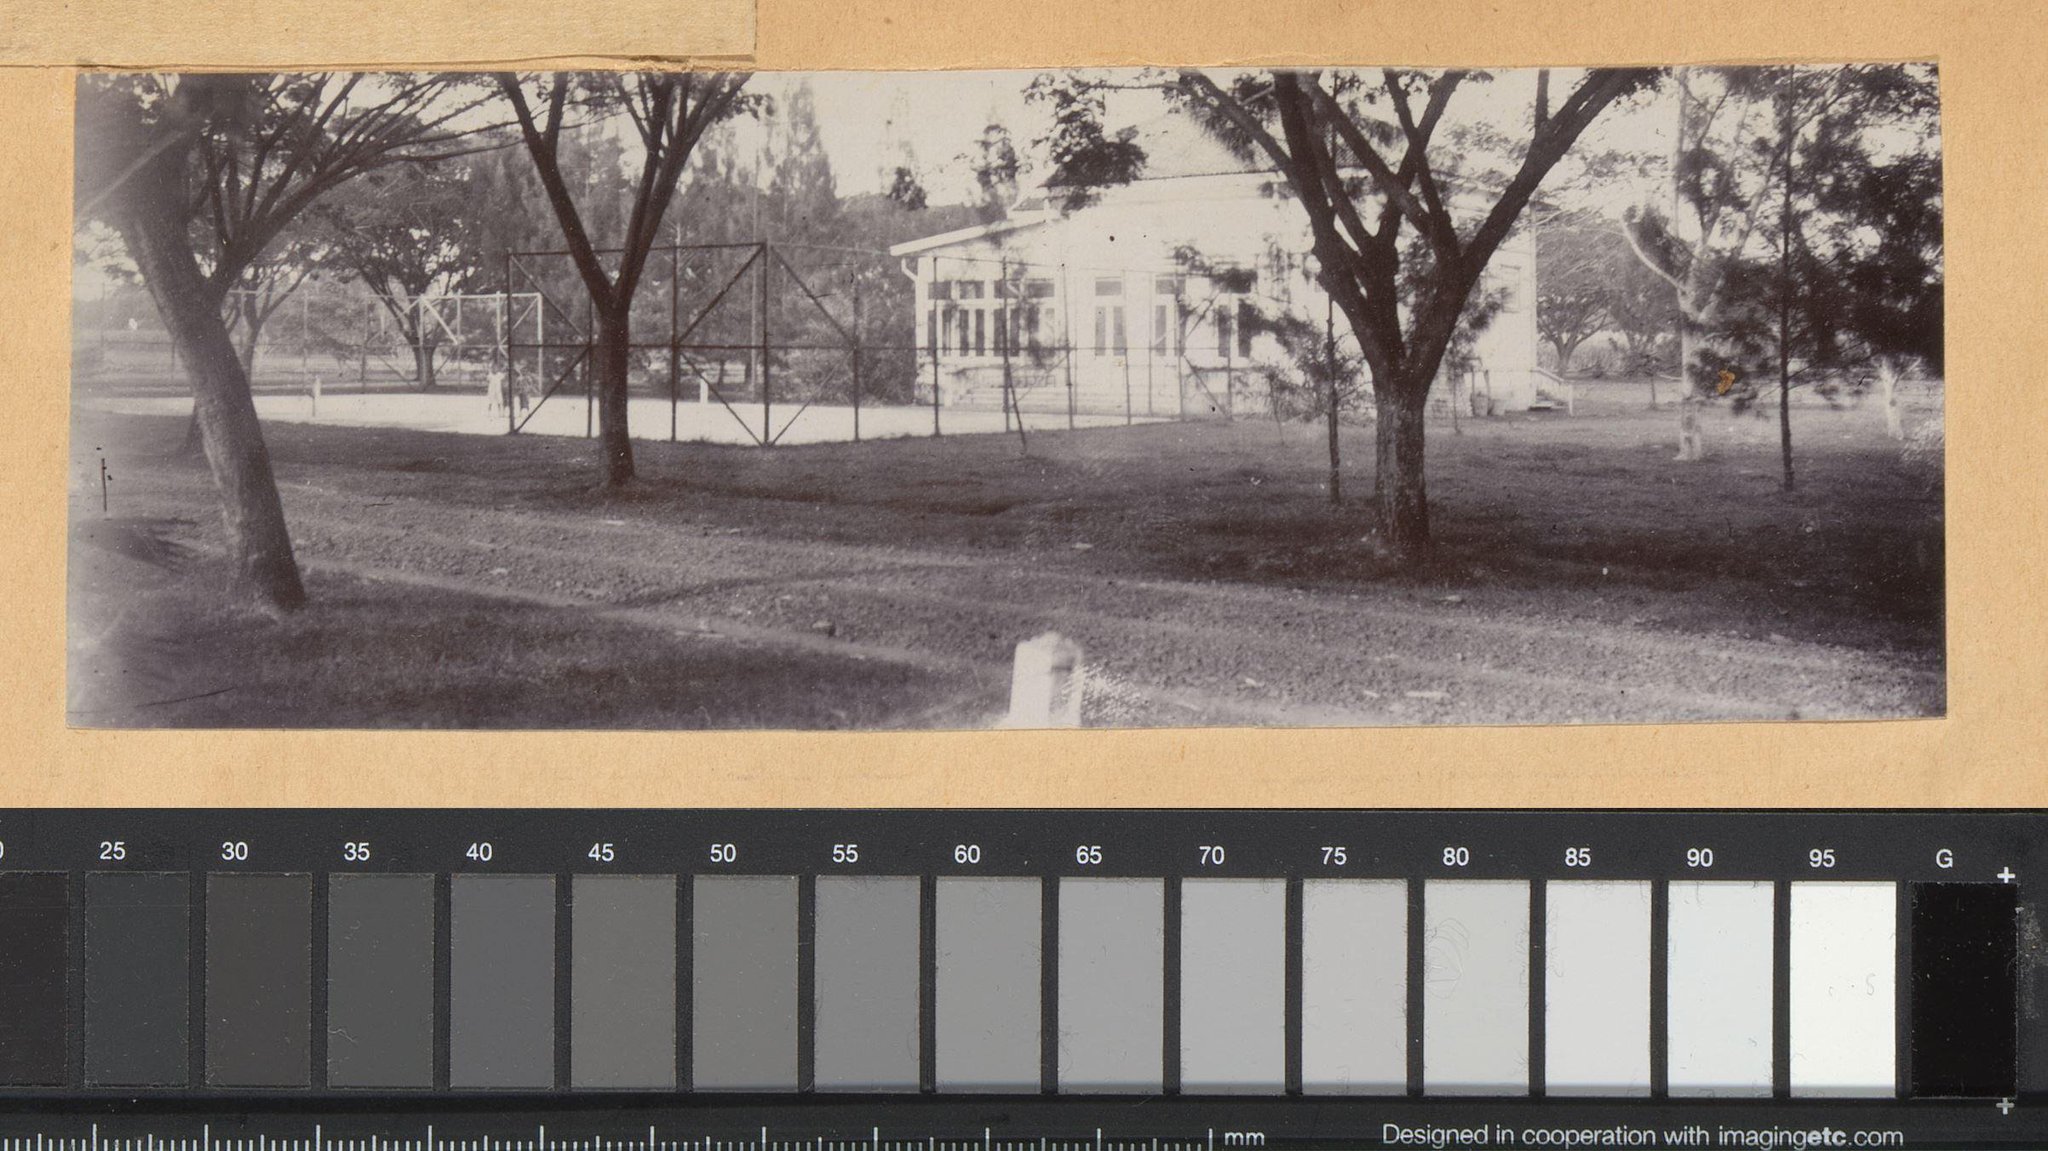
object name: panoramic photograph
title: Gezicht op een huis met tennisbaan in Nederlands-Indië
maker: Anonymous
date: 1917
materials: photographic support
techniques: gelatin silver print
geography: dutch east indies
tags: tennis, lawn-tennis, rural housing, e.g. country-house, villa, cottage, dutch east indies, the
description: Onderdeel van Familiealbum met foto's van een familie in de voormalige kolonie Nederlands-Indië en van een suikerfabriek in Purworejo.